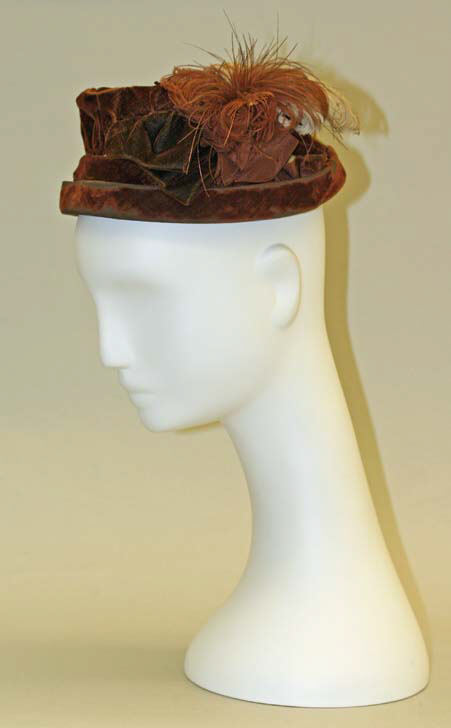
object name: bonnet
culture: american or european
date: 1860-1870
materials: wool